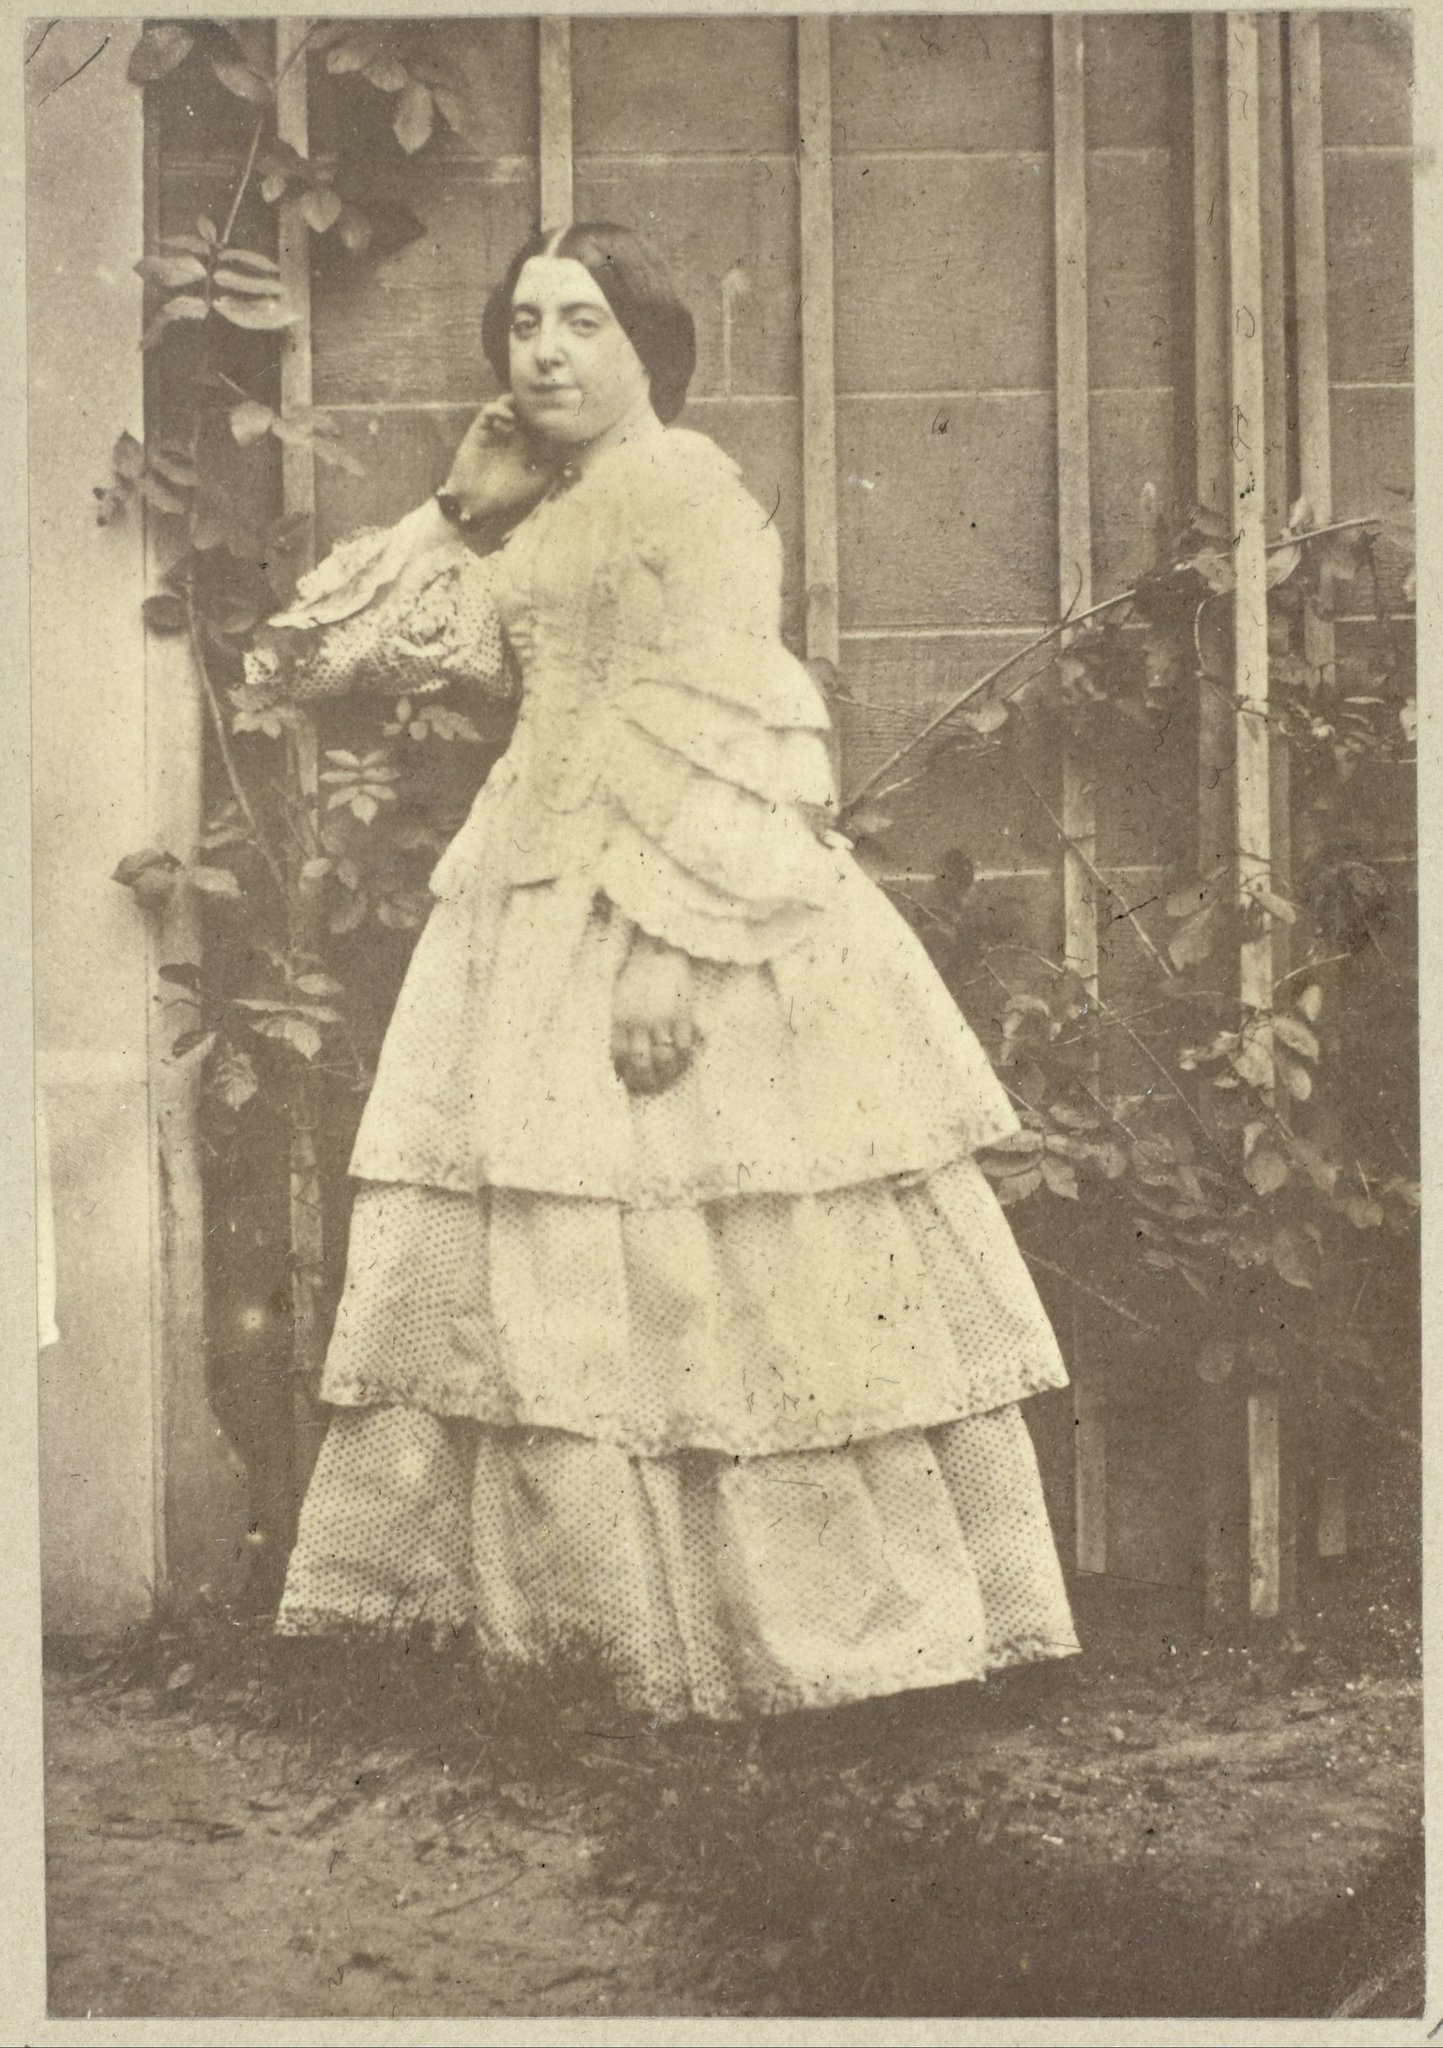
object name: photograph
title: Portret van een jonge vrouw in een tuin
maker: eduard isaac asser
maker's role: amateurfotograaf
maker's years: 1809-1894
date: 1853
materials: cardboard, paper, photographic support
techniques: salted paper print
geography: amsterdam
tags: historical persons - bb - woman, netherlands